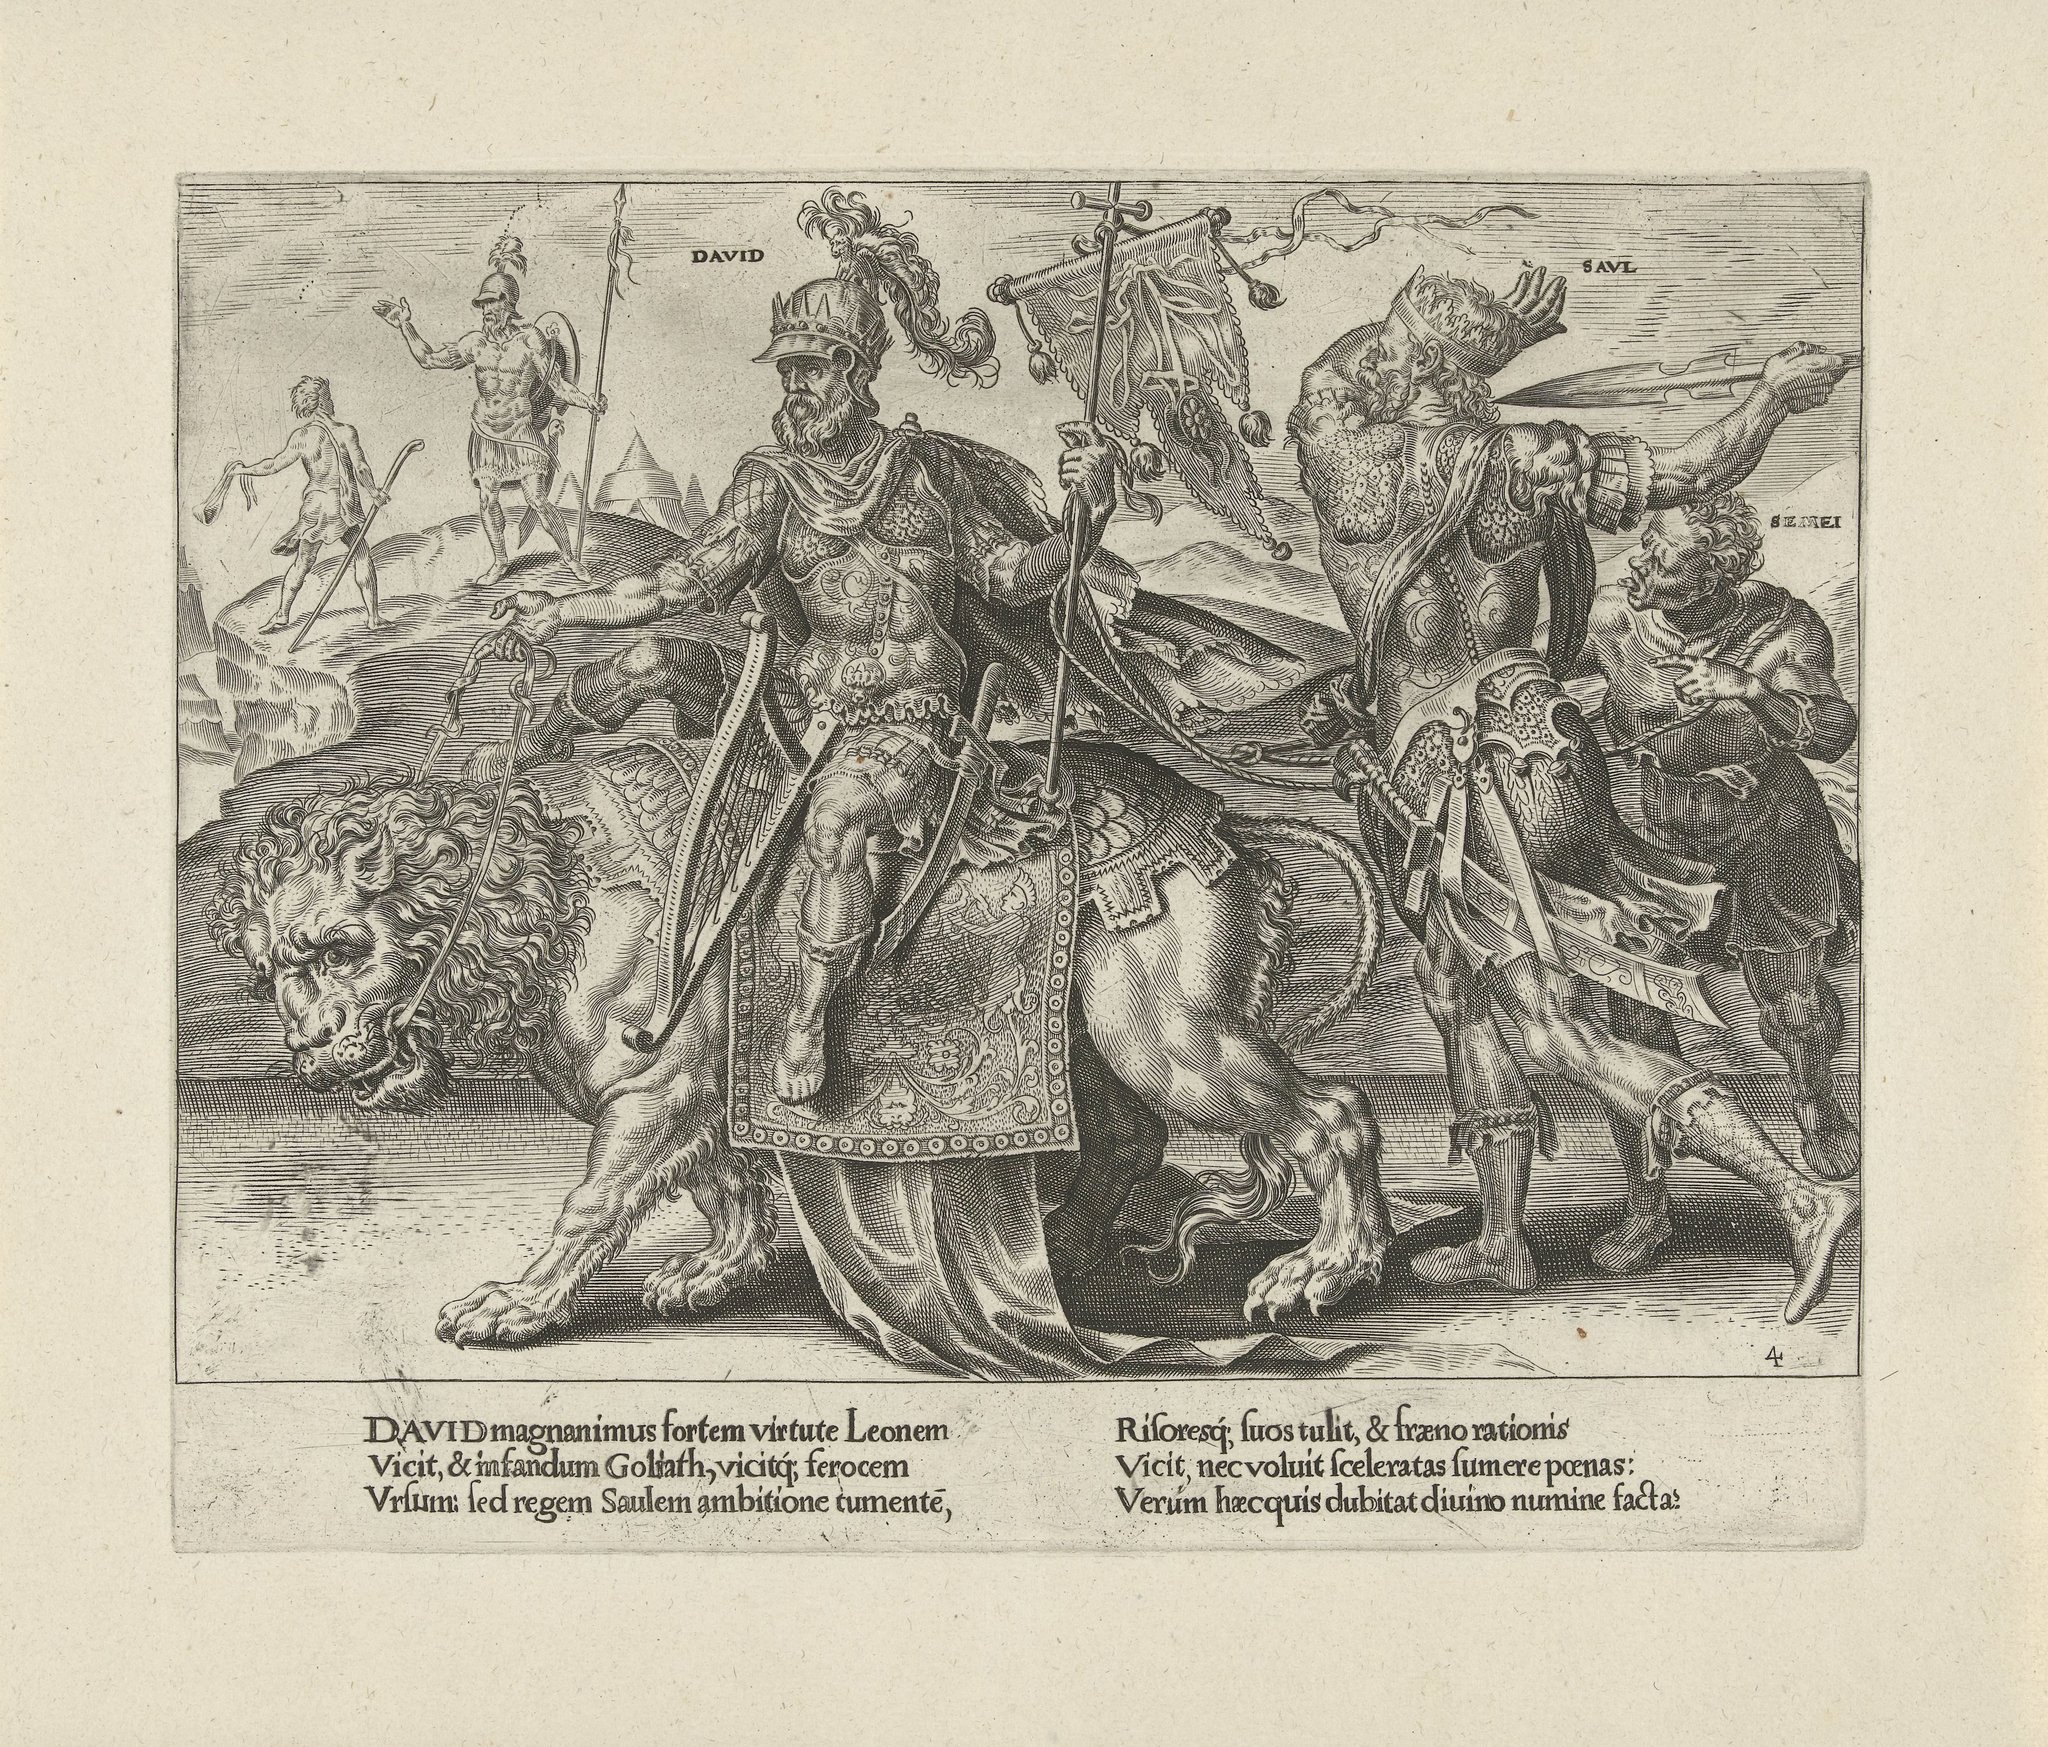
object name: print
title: Patientiae Trivmphvs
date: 1559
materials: paper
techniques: engraving, etching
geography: antwerp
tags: david (not in biblical context); possible attributes: crown, harp, triumphs (allegorical and symbolic), david fighting goliath, shimei curses david and casts stones at him, saul casts his spear at david for the second time (1 samuel 19:10), beasts of prey, predatory animals: lion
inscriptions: collector's mark: Lugt 2228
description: Op de voorgrond David met zijn harp, rijdend op een leeuw. In zijn linkerhand een kruis met een vaandel. Op het vaandel de teugels van de ratio. Achter David volgen Saul, die hem met een speer bedreigt en Semel die hem vervloekt. Beiden worden ongehinderd gelaten door David. Op de achtergrond het gevecht tussen David en Goliat. De prent heeft een Latijns opschrift van zes regels en maakt deel uit van een achtdelige serie over de triomf van de Lijdzaamheid.